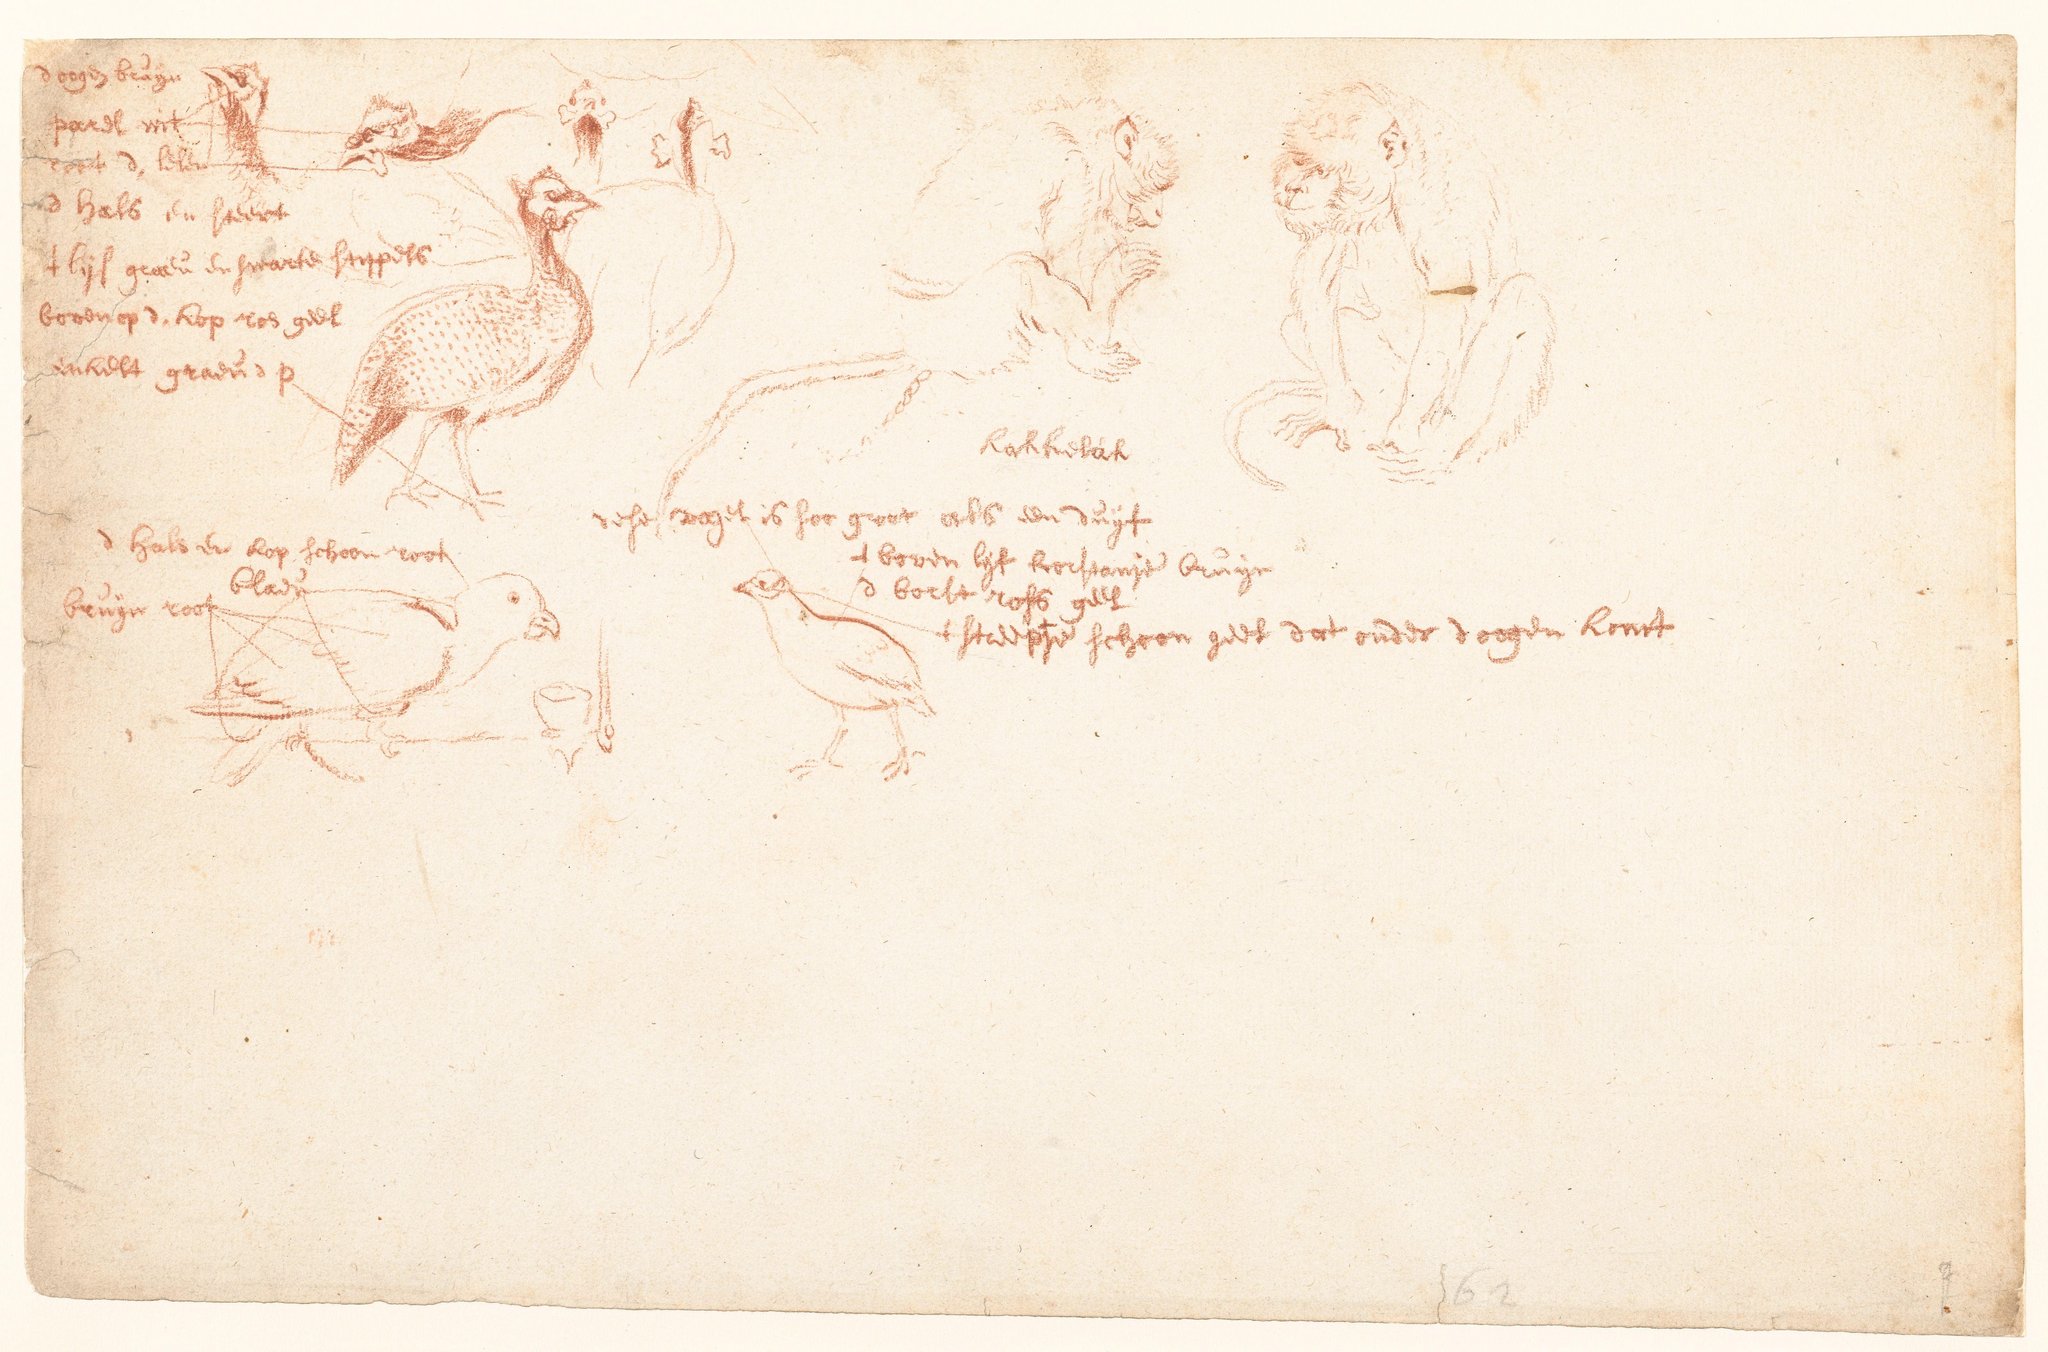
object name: drawing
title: Reisschetsen gemaakt in Indië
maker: Anonymous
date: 1700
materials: chalk, paper